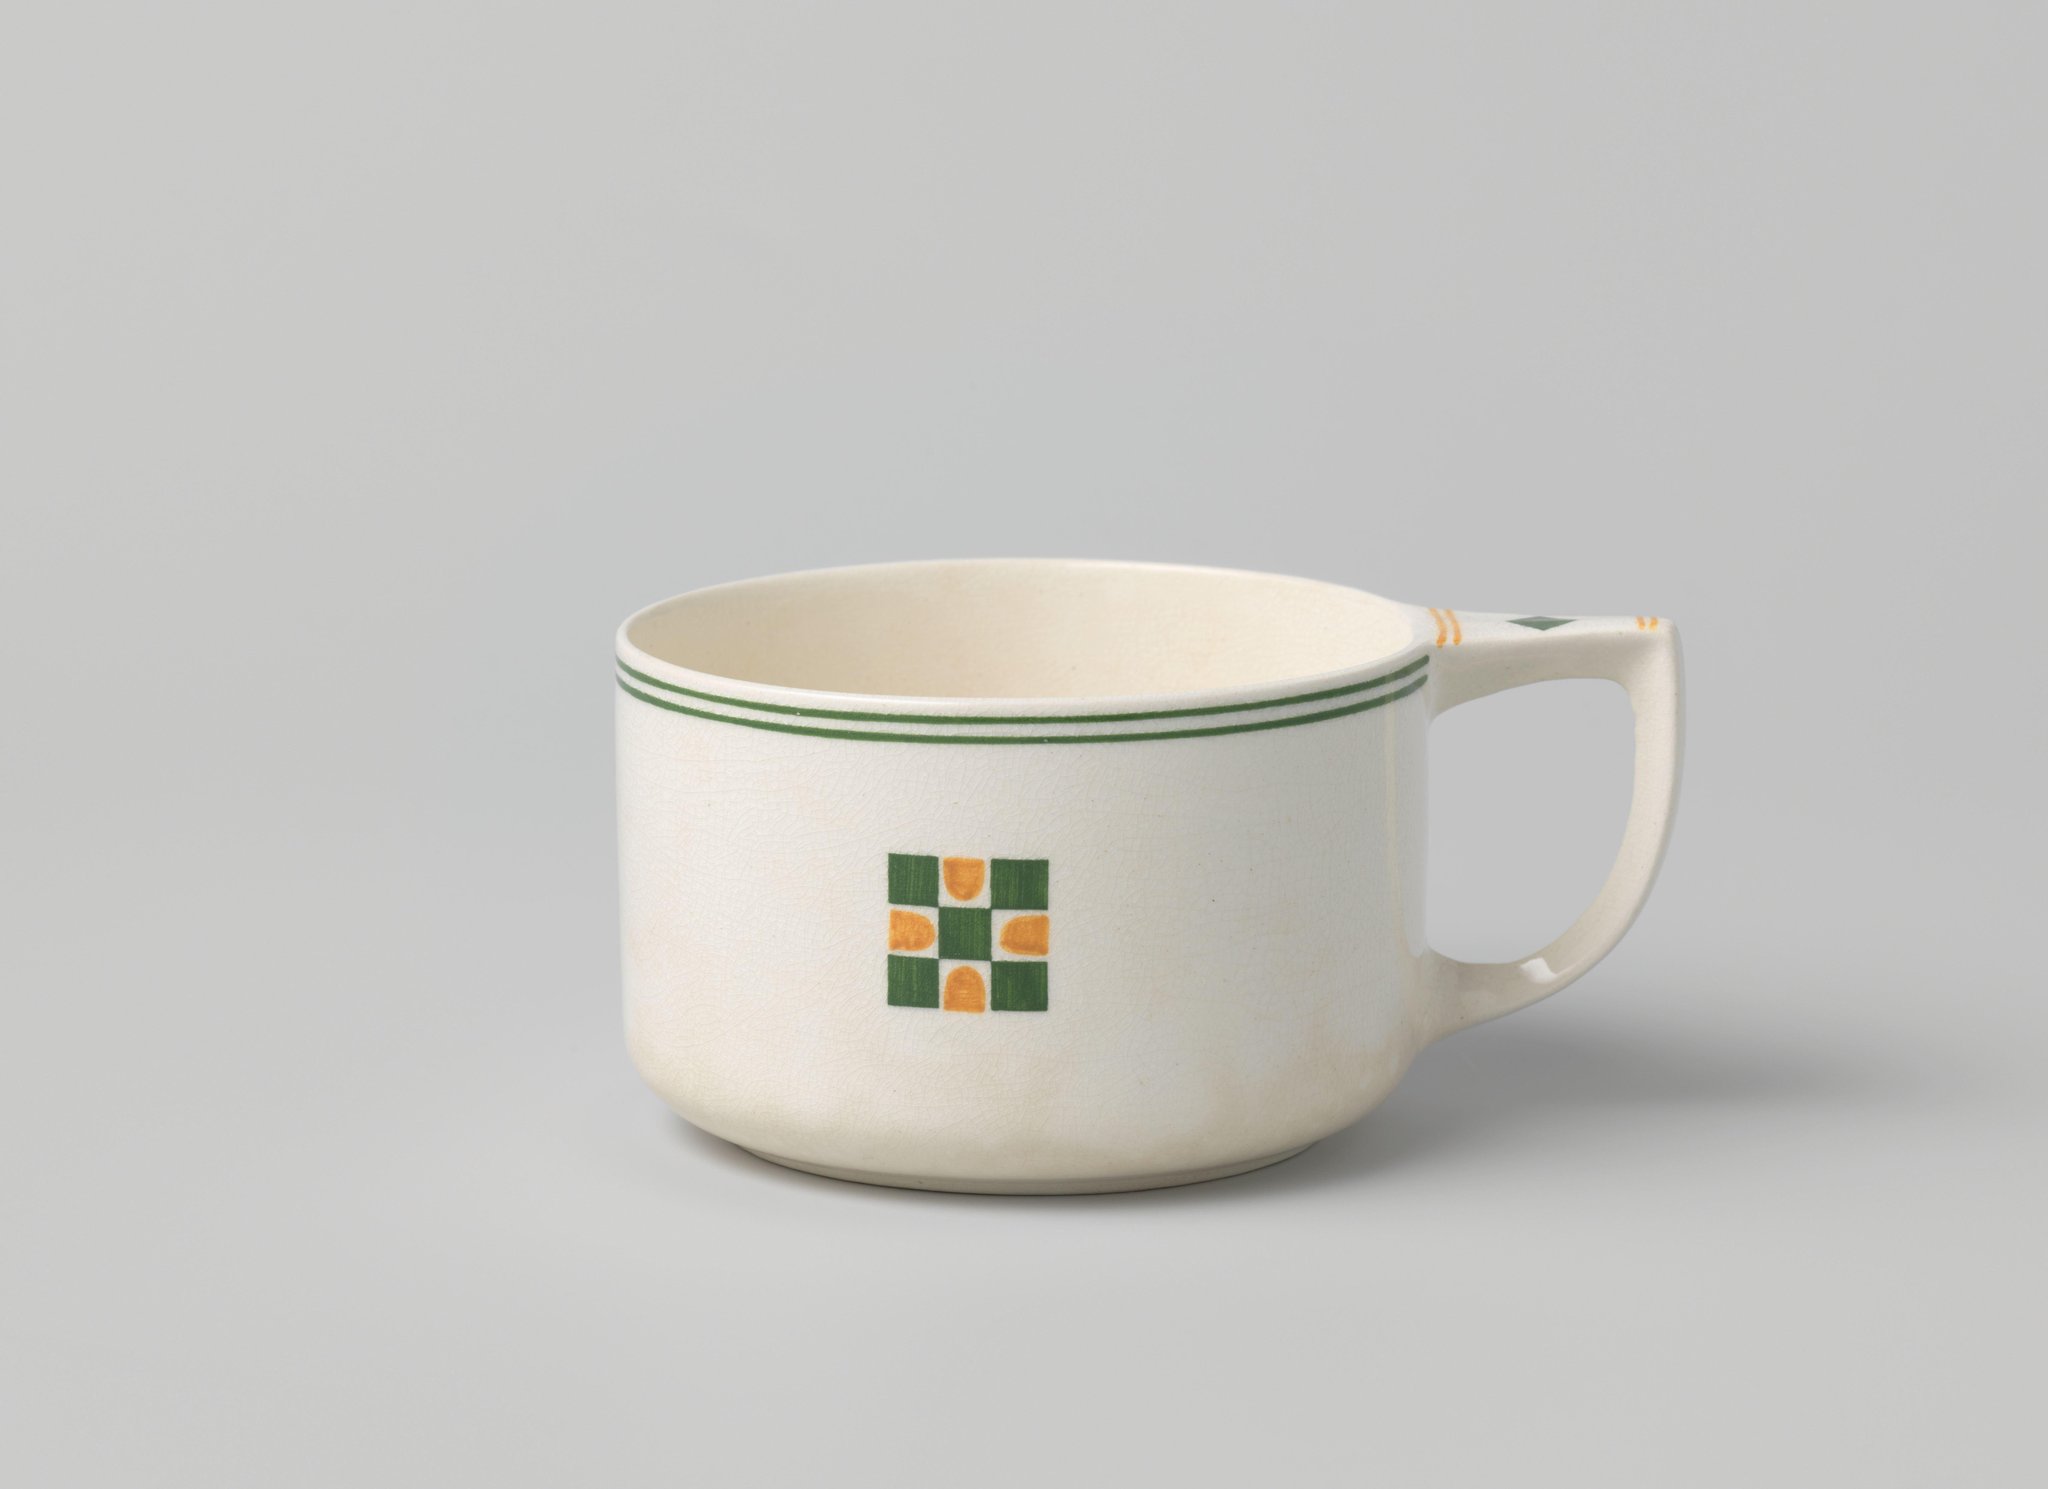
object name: soup bowl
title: Soepkop van aardewerk, versierd met een blokpatroon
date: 1900-1925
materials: earthenware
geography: gouda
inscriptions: mark: ‘fabrieksmerk (in zwart) ; 4044, 1000 en II (in geel)’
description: Soepkop van aardewerk, versierd met een blokpatroon in groen en geel.